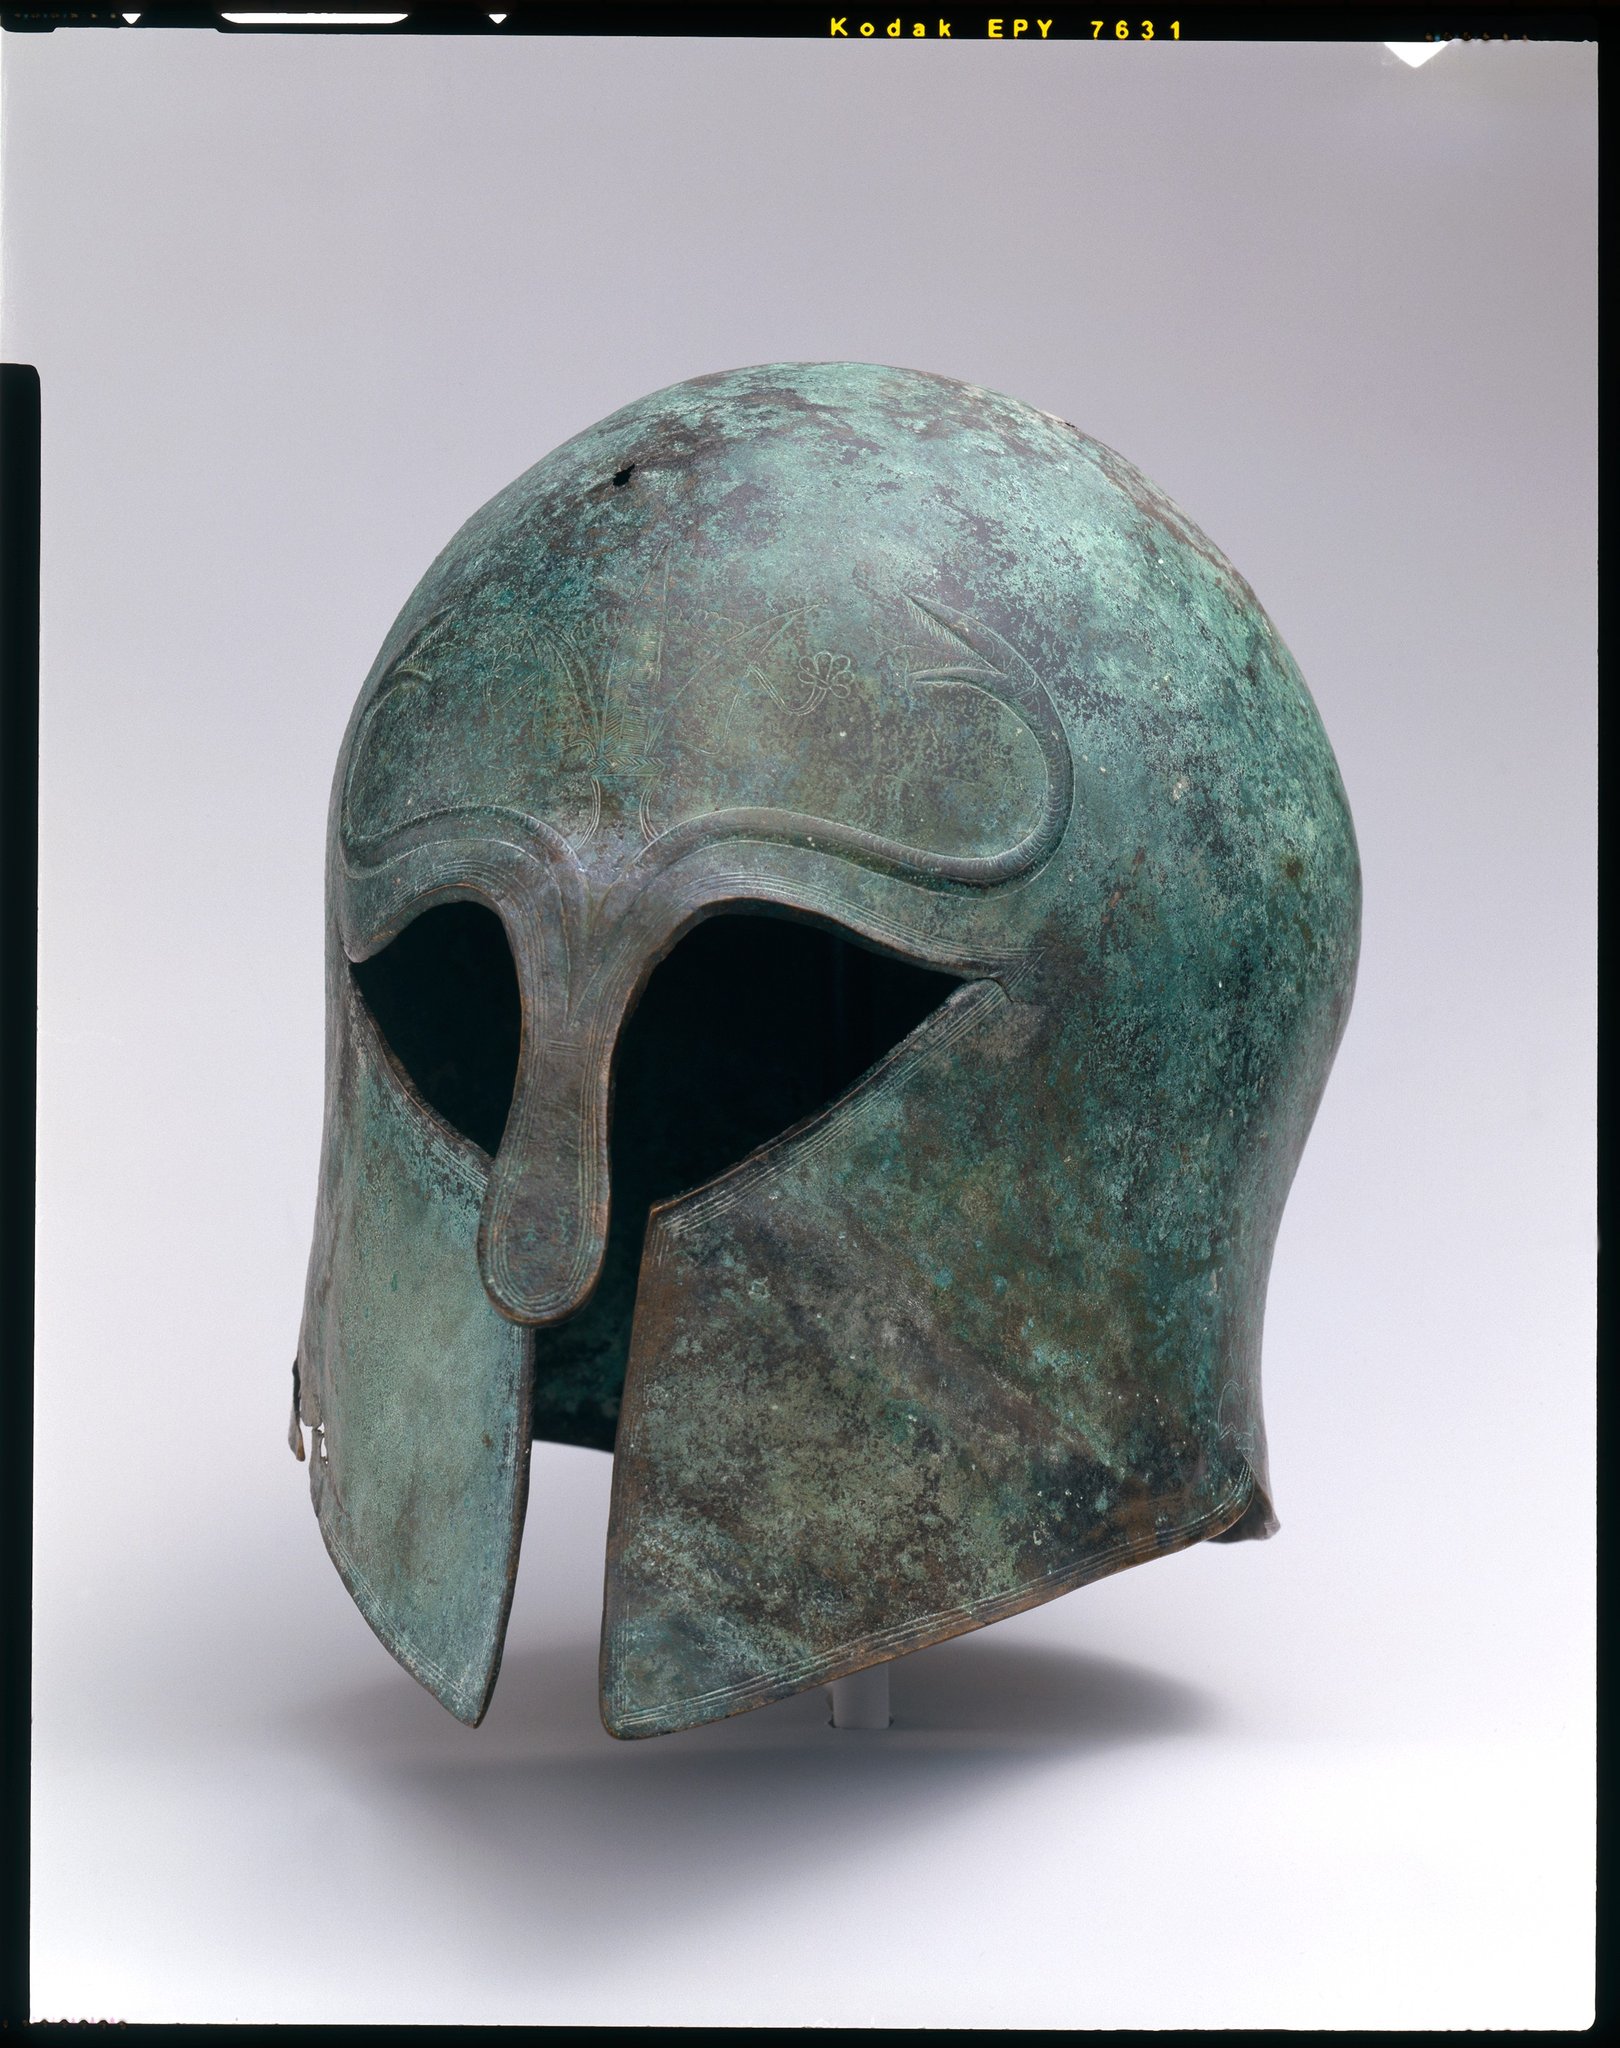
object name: helmet of corinthian type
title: Bronze helmet of Corinthian type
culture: greek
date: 600-575 BCE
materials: bronze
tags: helmets